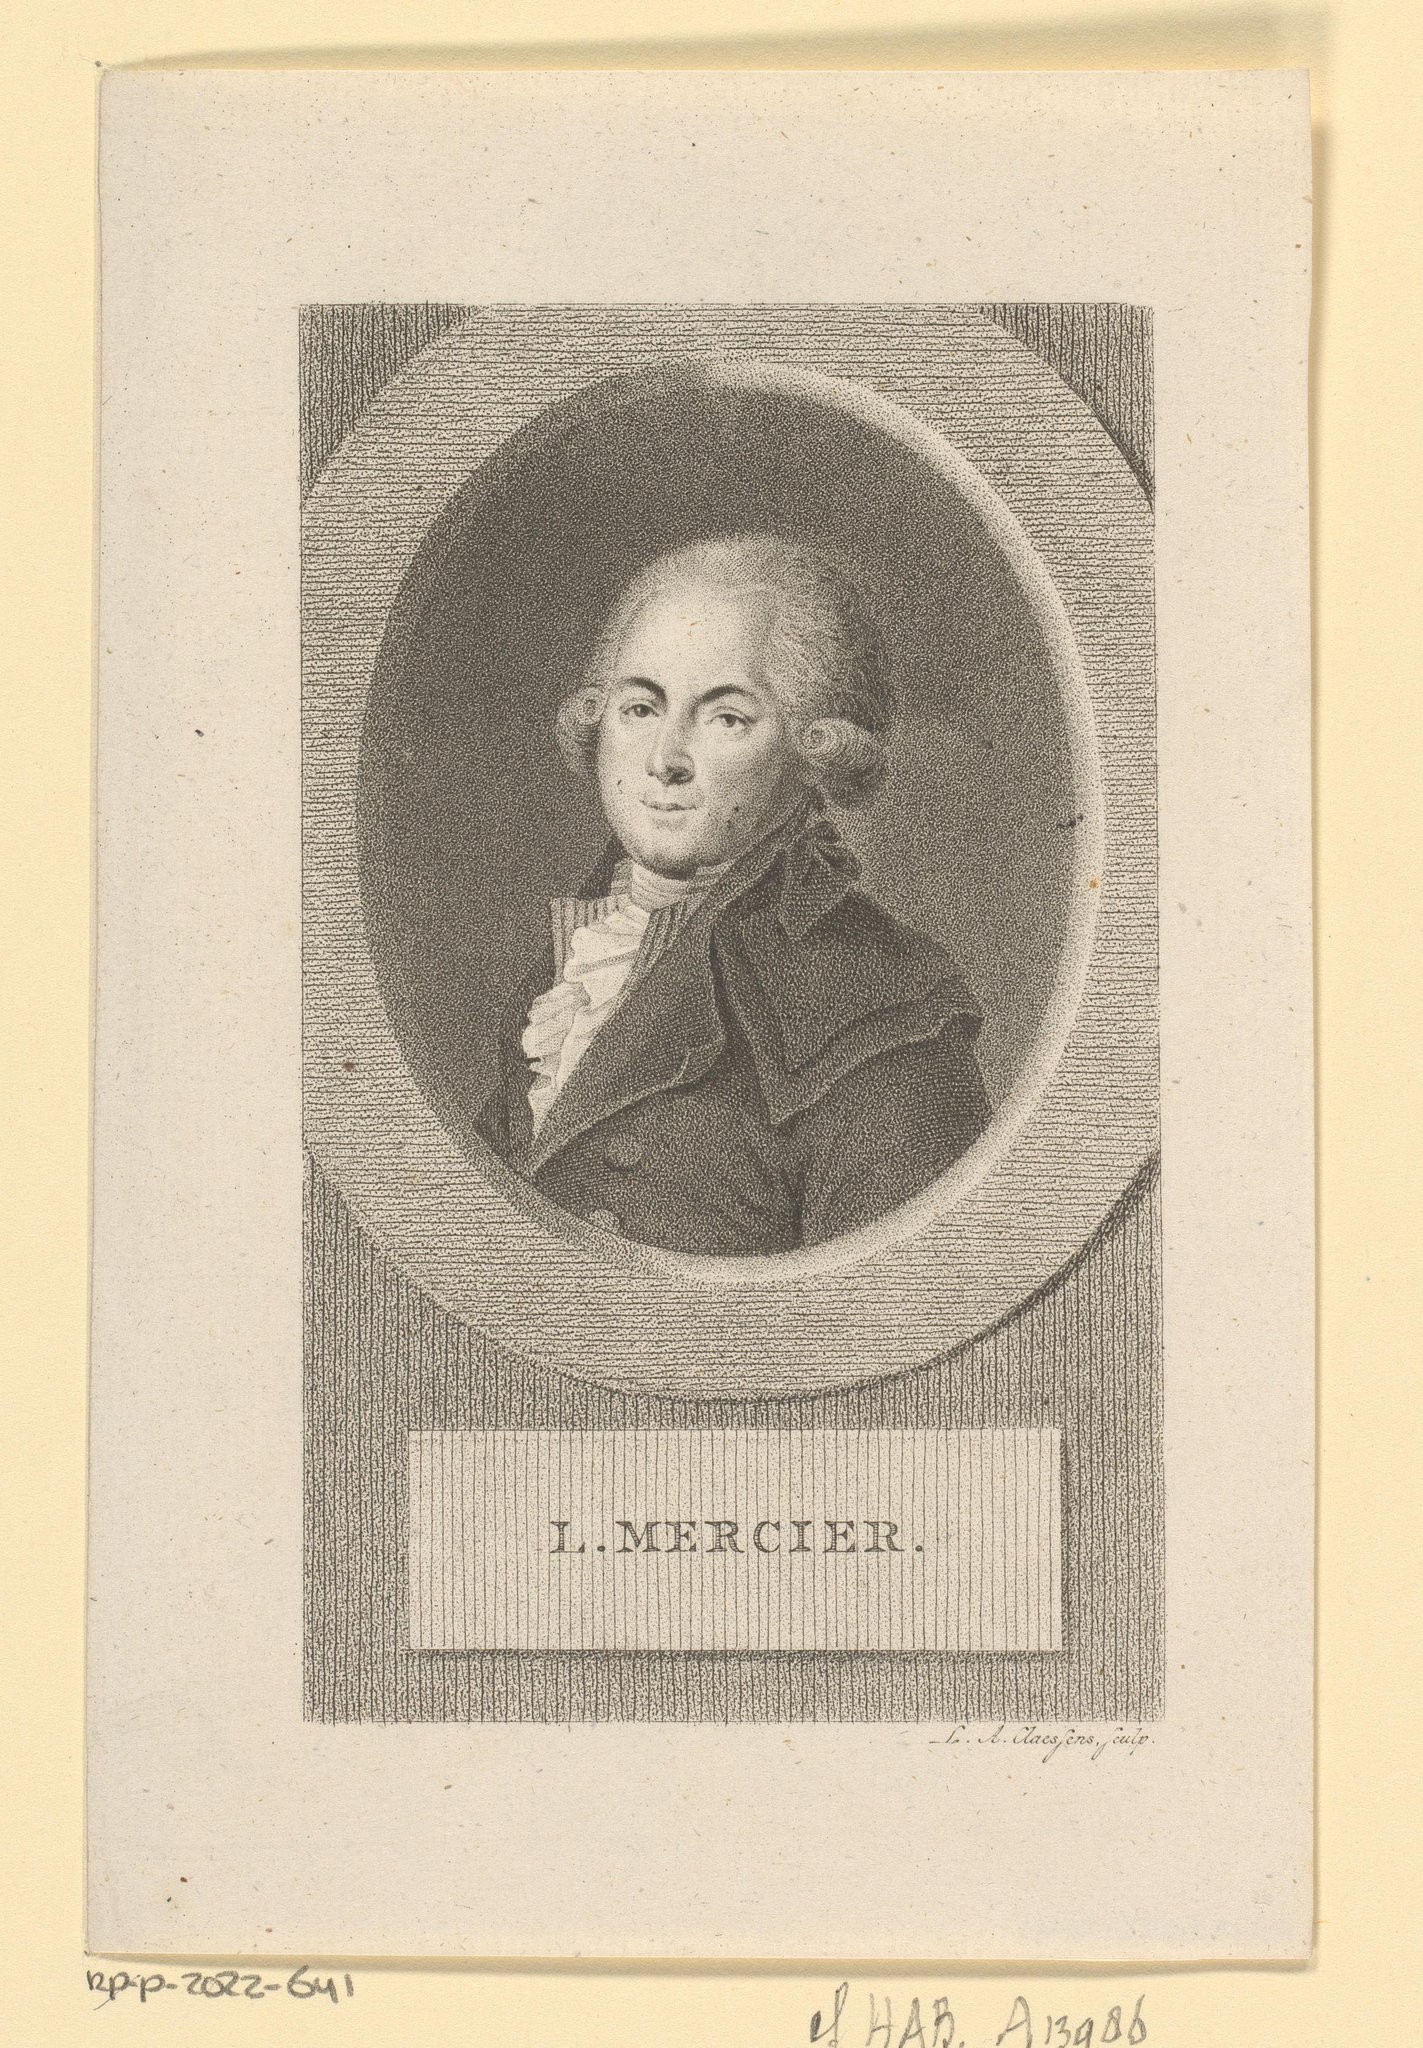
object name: print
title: L. Mercier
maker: lambertus antonius claessens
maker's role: draughtsman, print maker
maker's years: 1763-1834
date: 1773-1834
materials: paper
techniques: etching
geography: amsterdam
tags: paris, historical persons